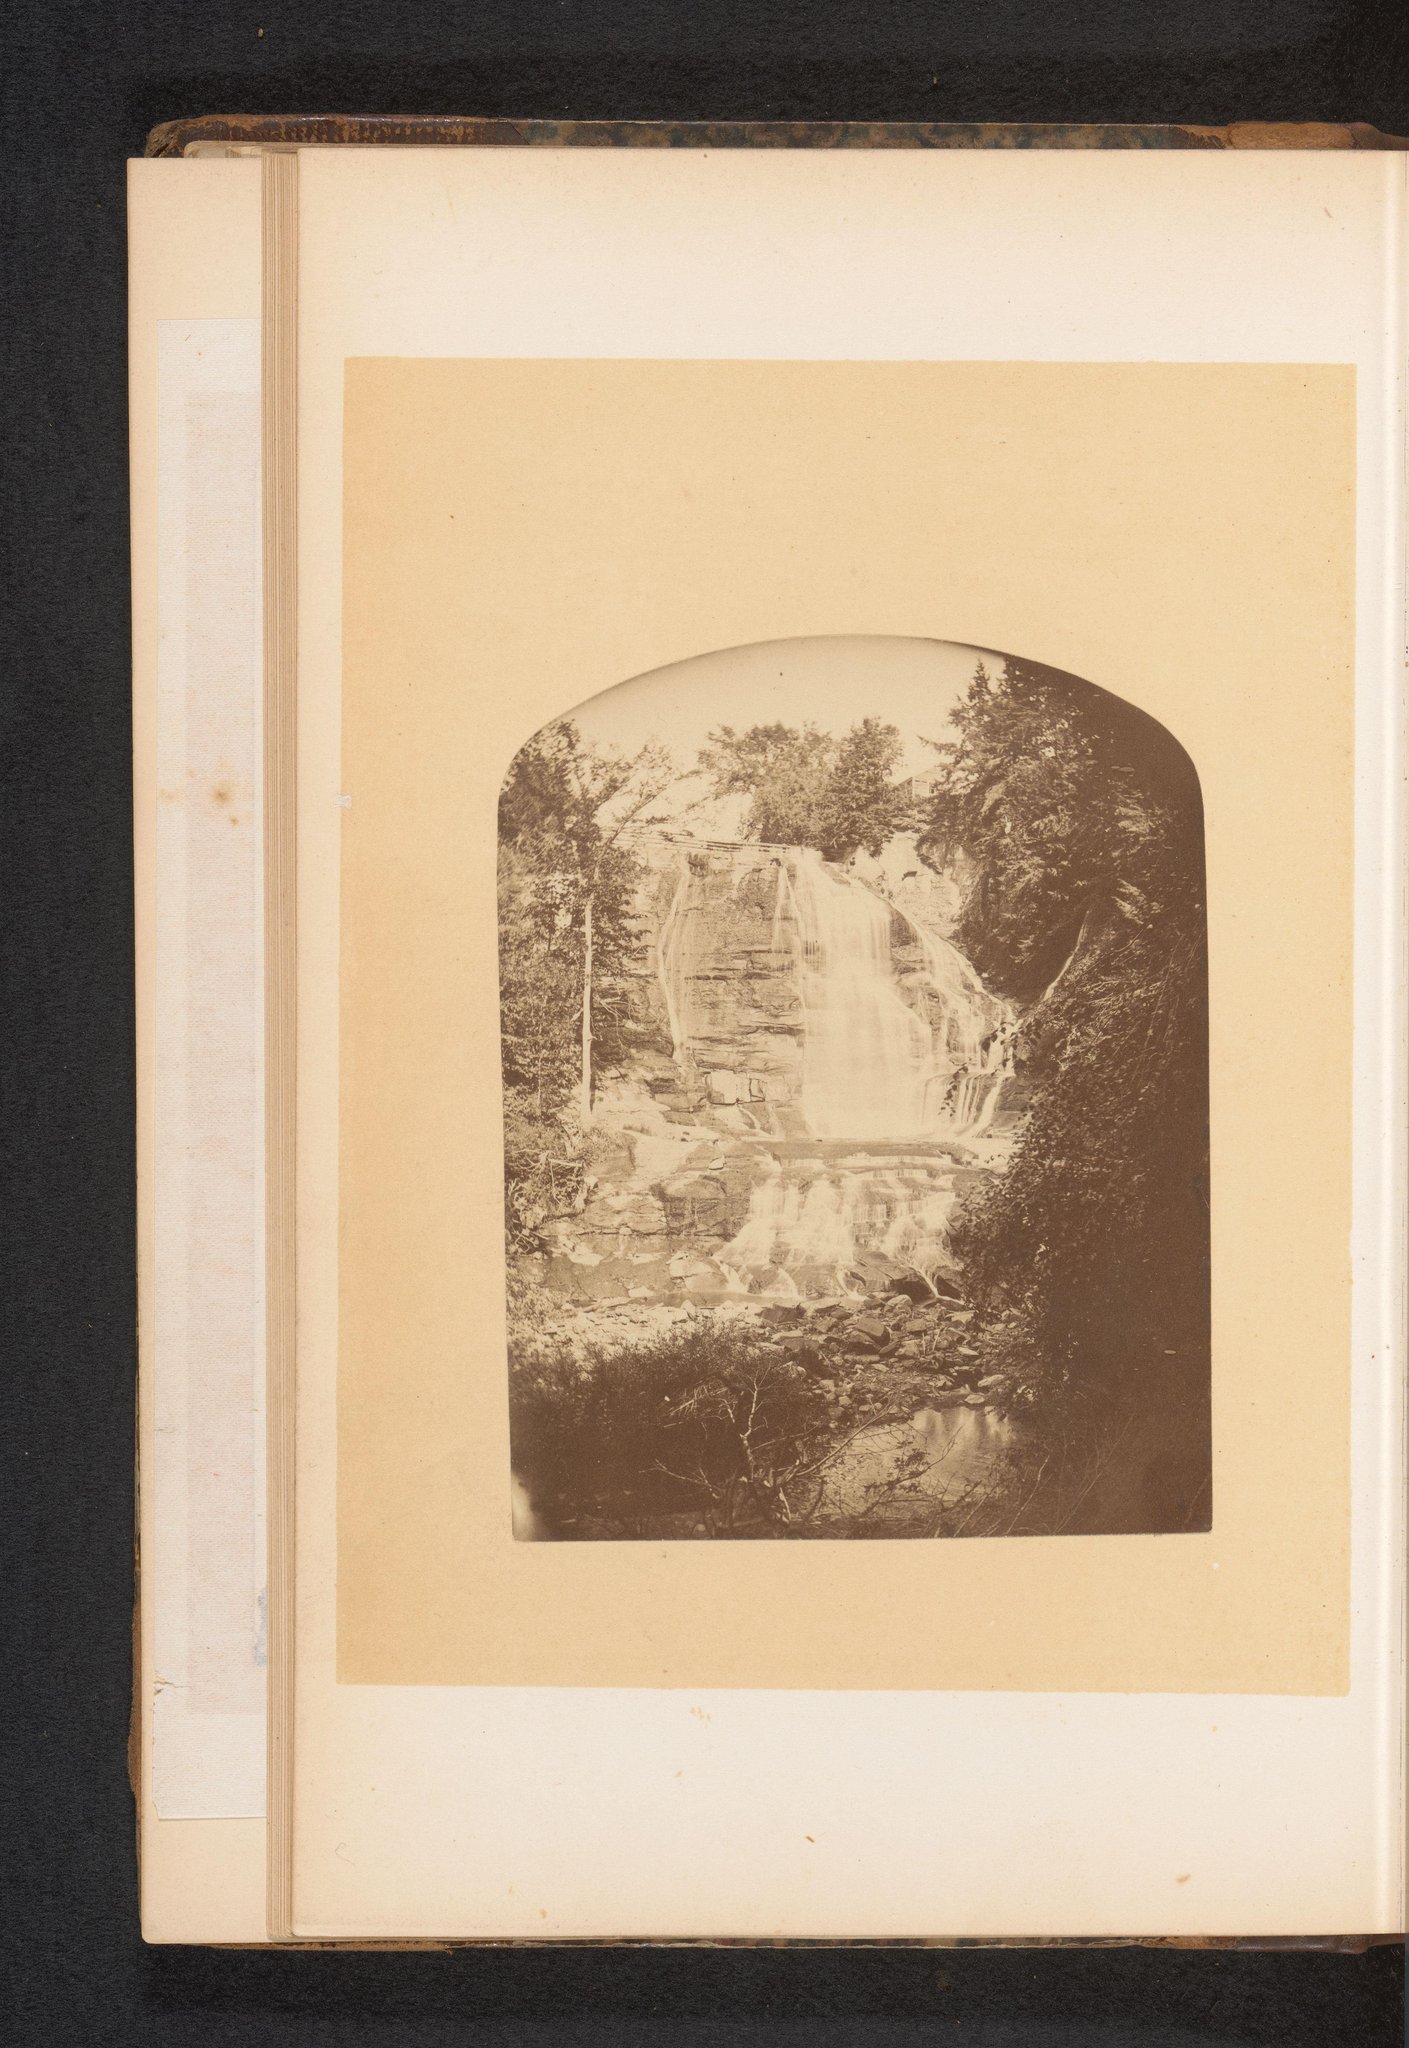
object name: page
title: Gezicht op Montville Falls, New York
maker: e.h. alley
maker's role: fotograaf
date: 1861-1866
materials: photographic support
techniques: albumen print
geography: montville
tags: waterfall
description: Foto tegenover pagina 65, achter semi-transparante omslag.